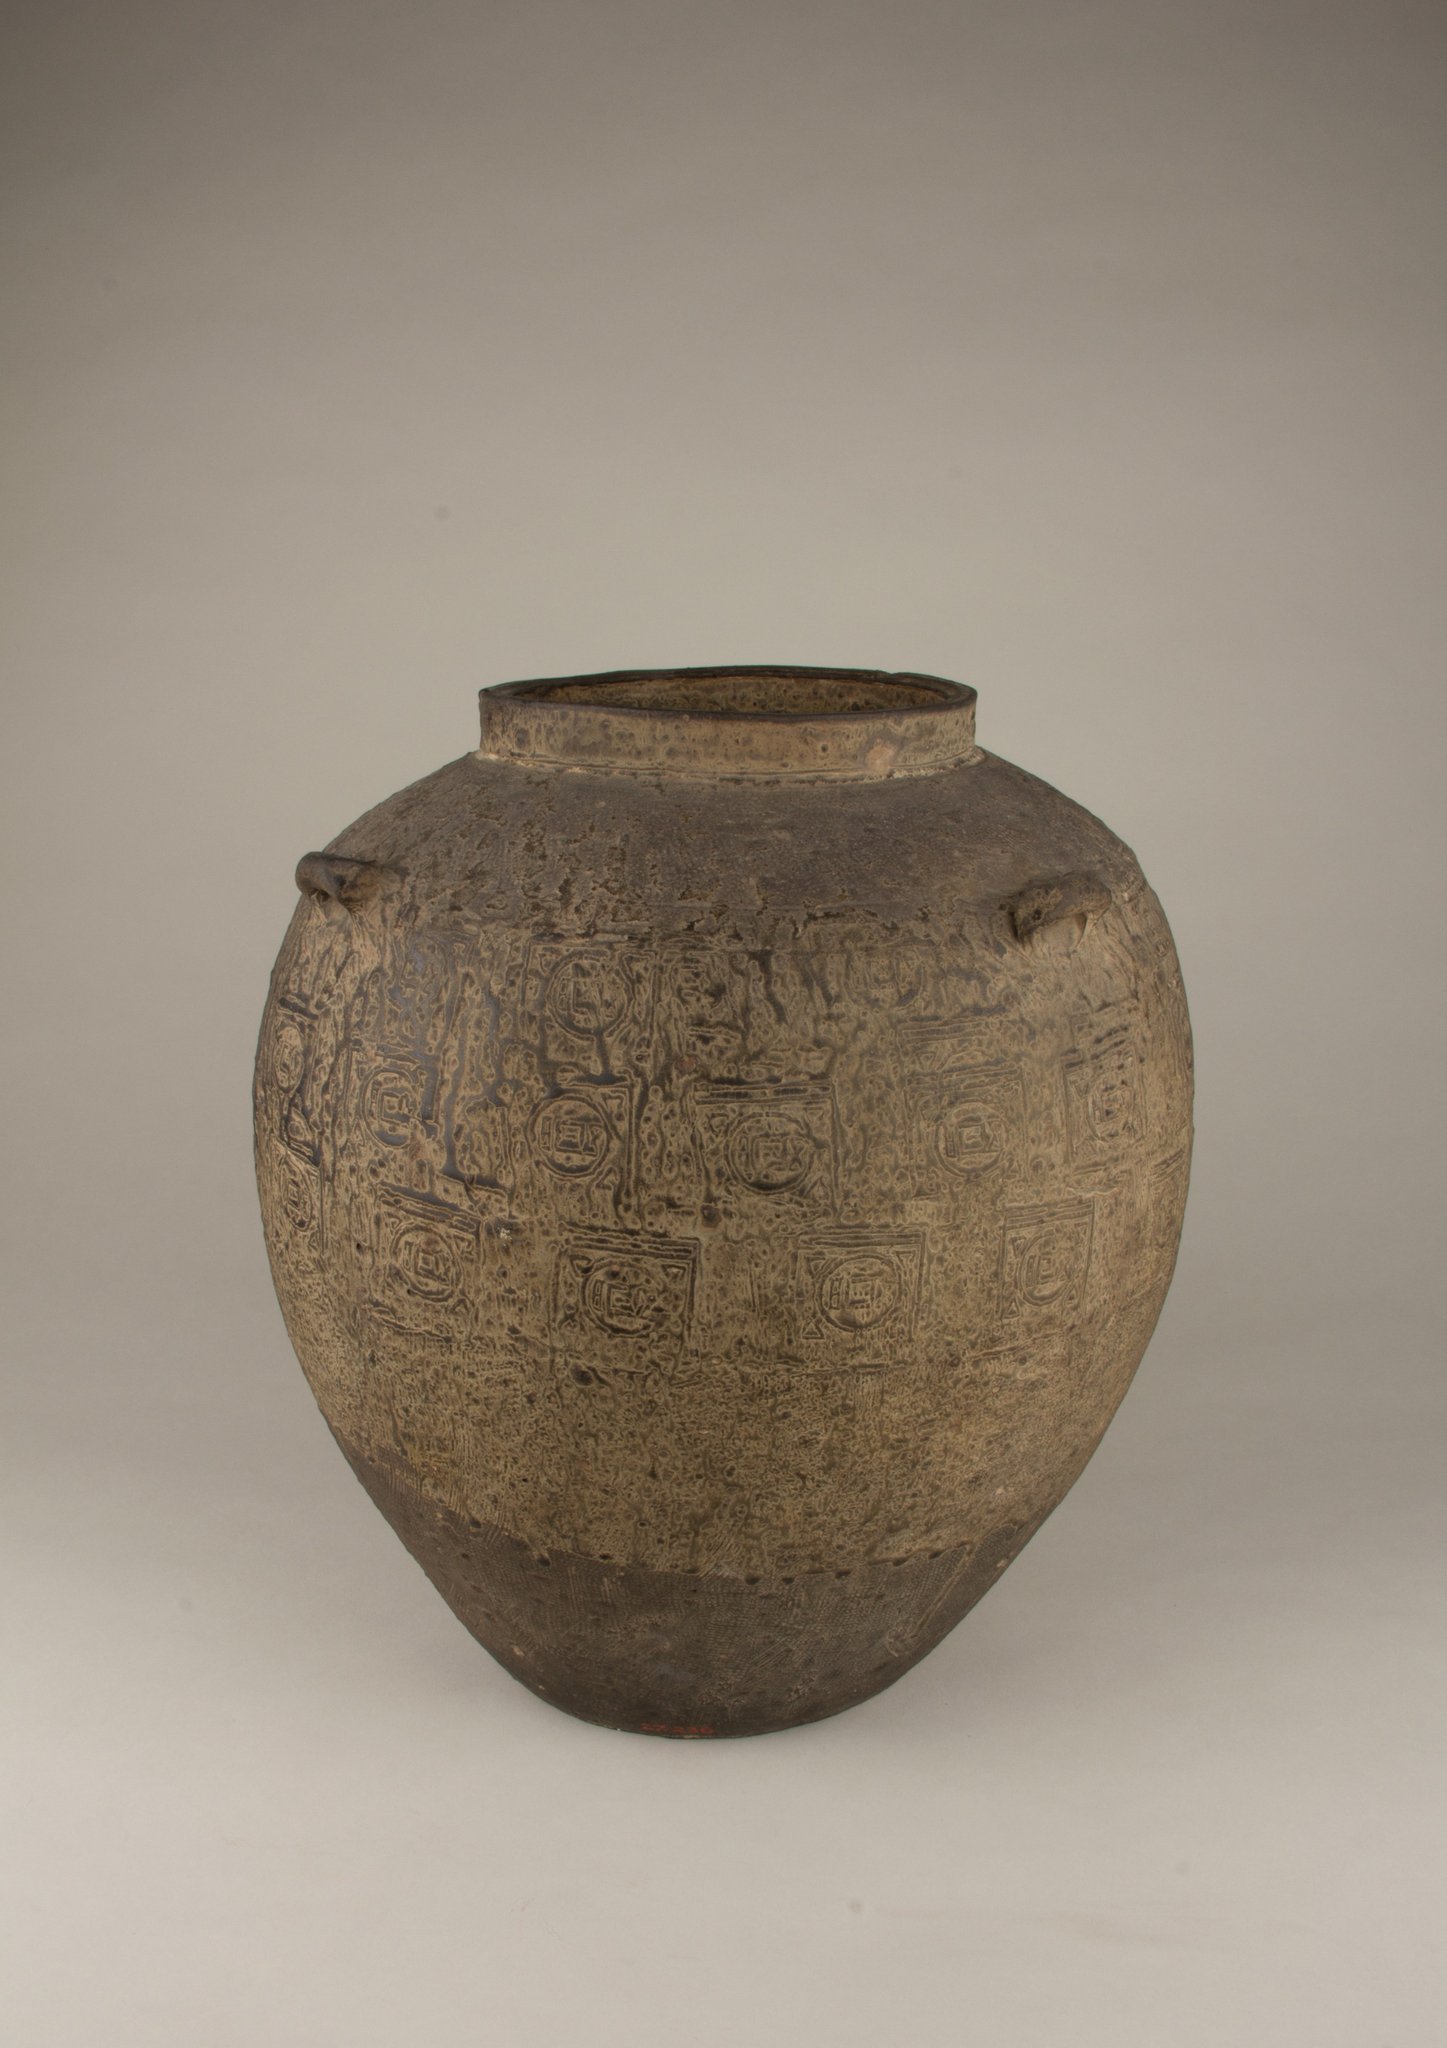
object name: jar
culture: chinese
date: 201-400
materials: glaze, stoneware